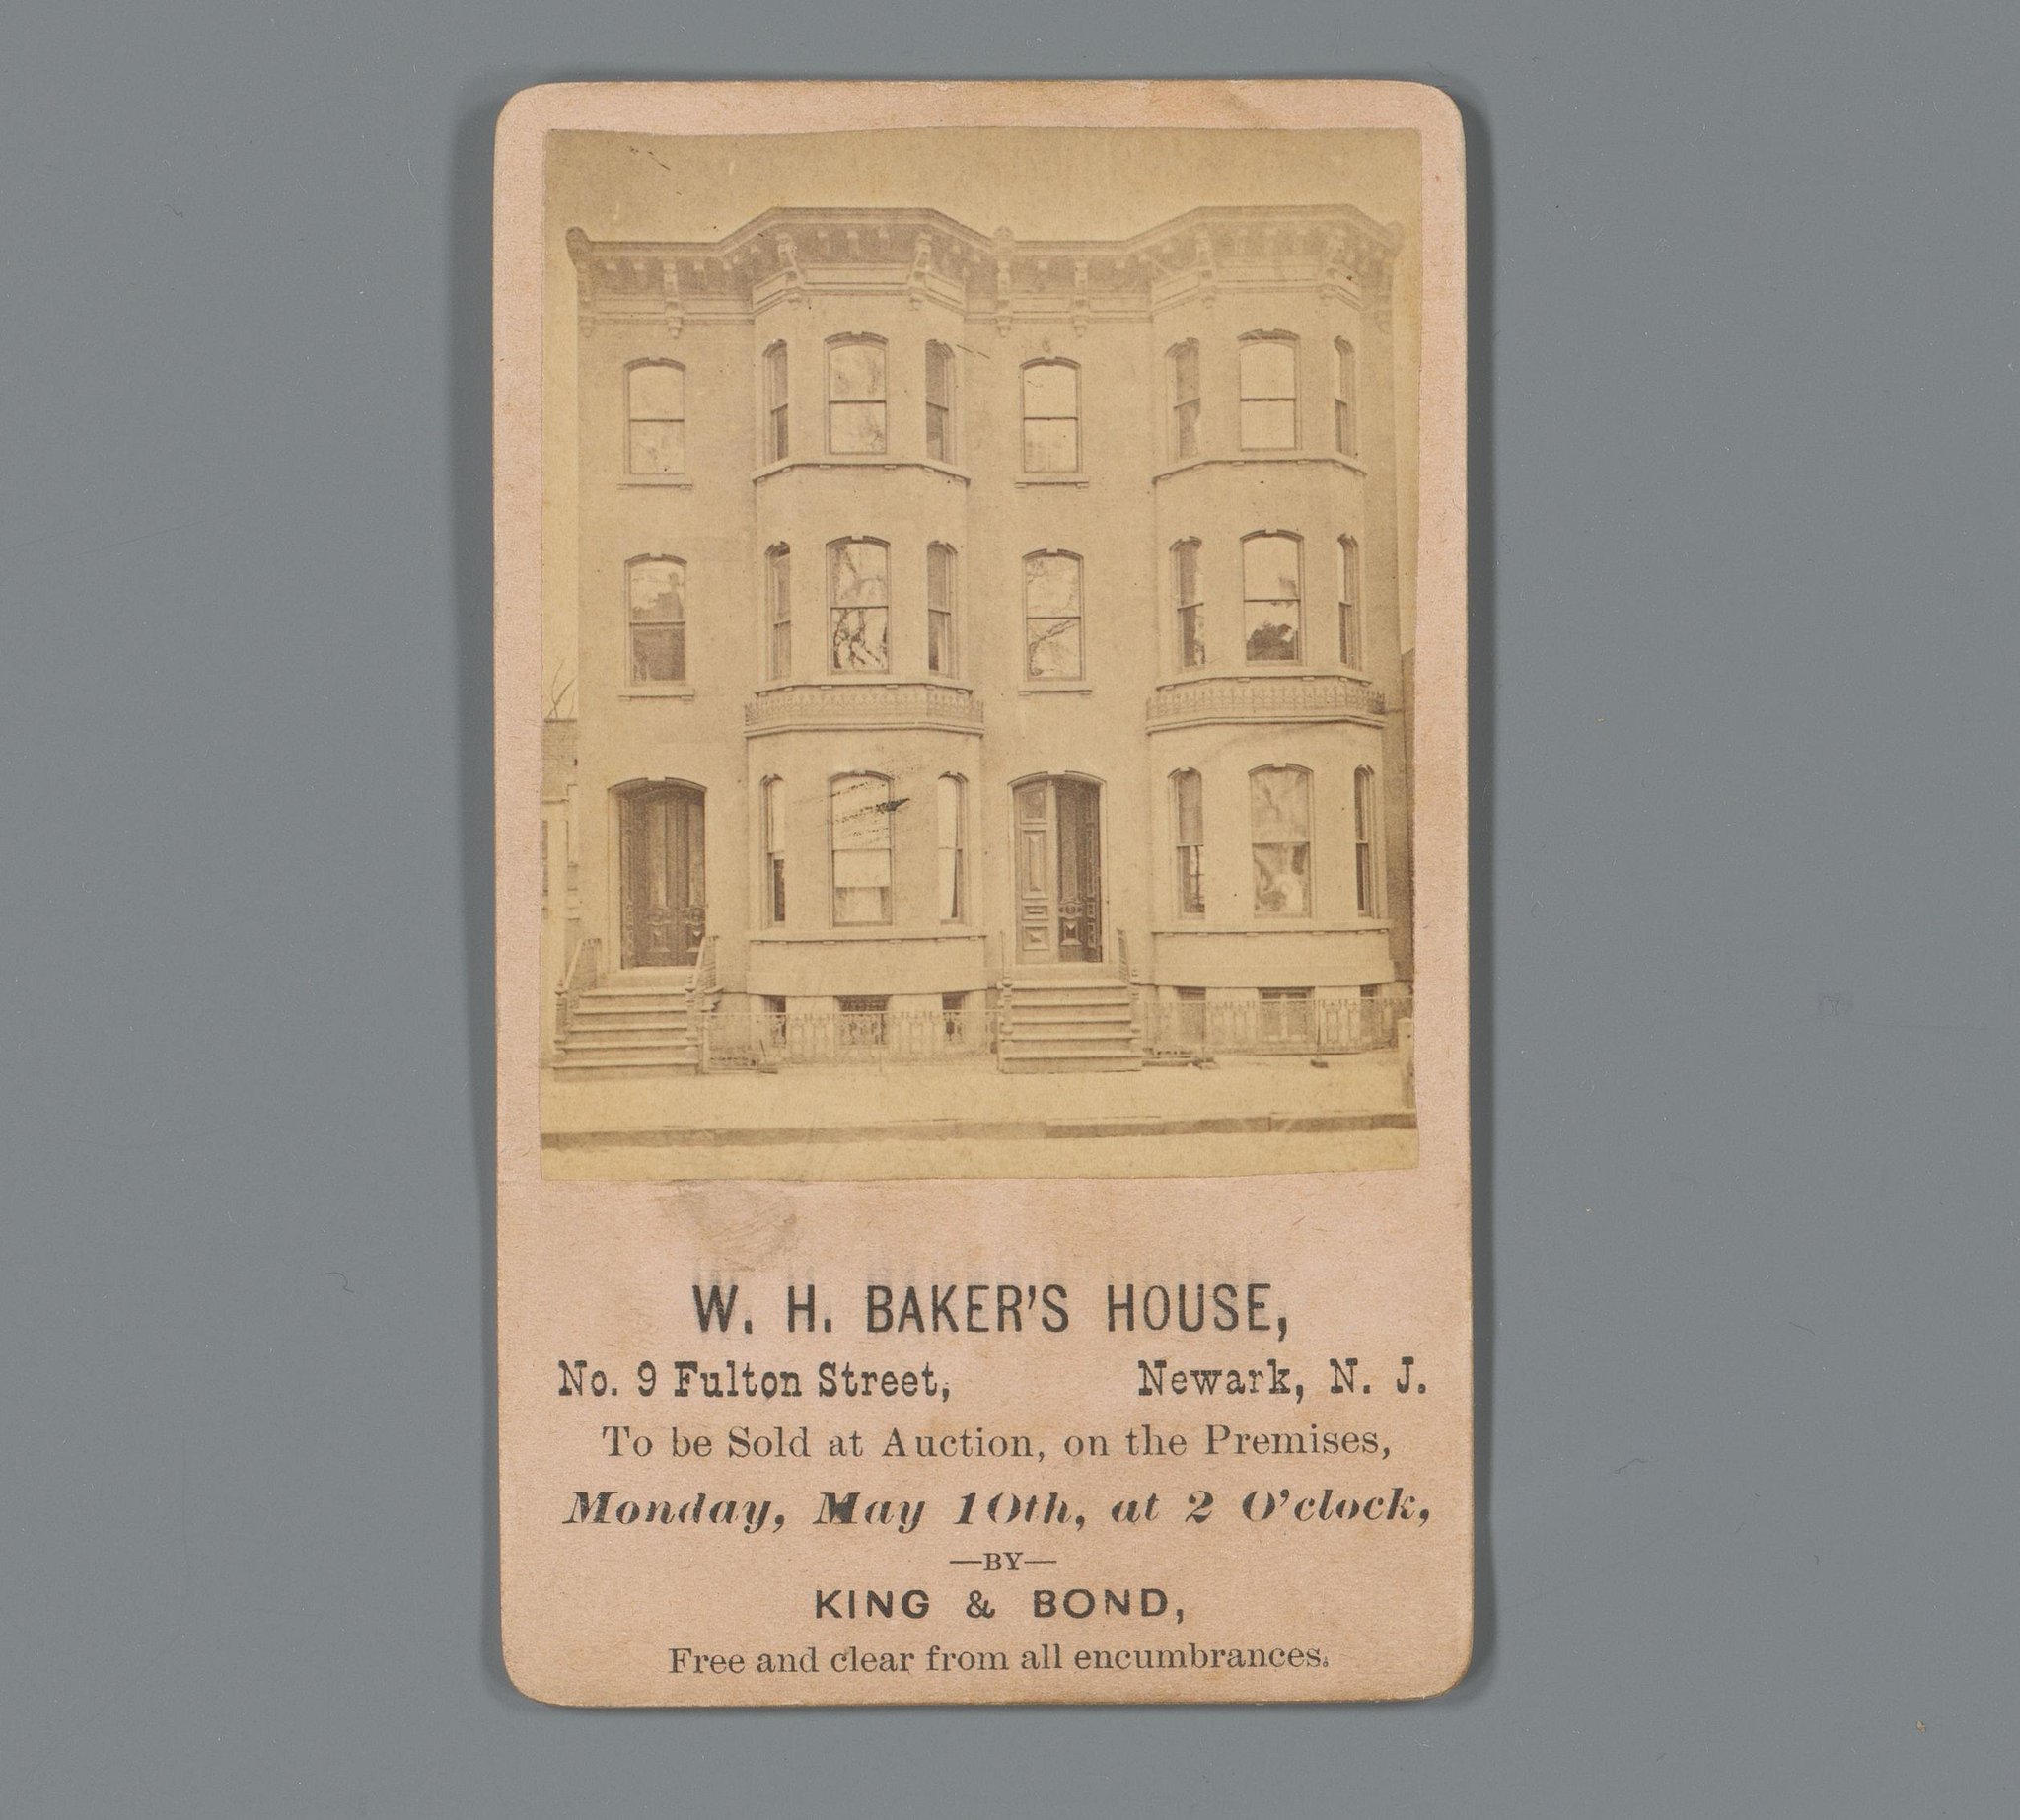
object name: photograph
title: Gezicht op een pand in de verkoop door King & Bond in Newark, New Jersey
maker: Anonymous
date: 1850-1915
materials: cardboard, photographic support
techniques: albumen print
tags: urban housing, advertising, auction sale, public sale